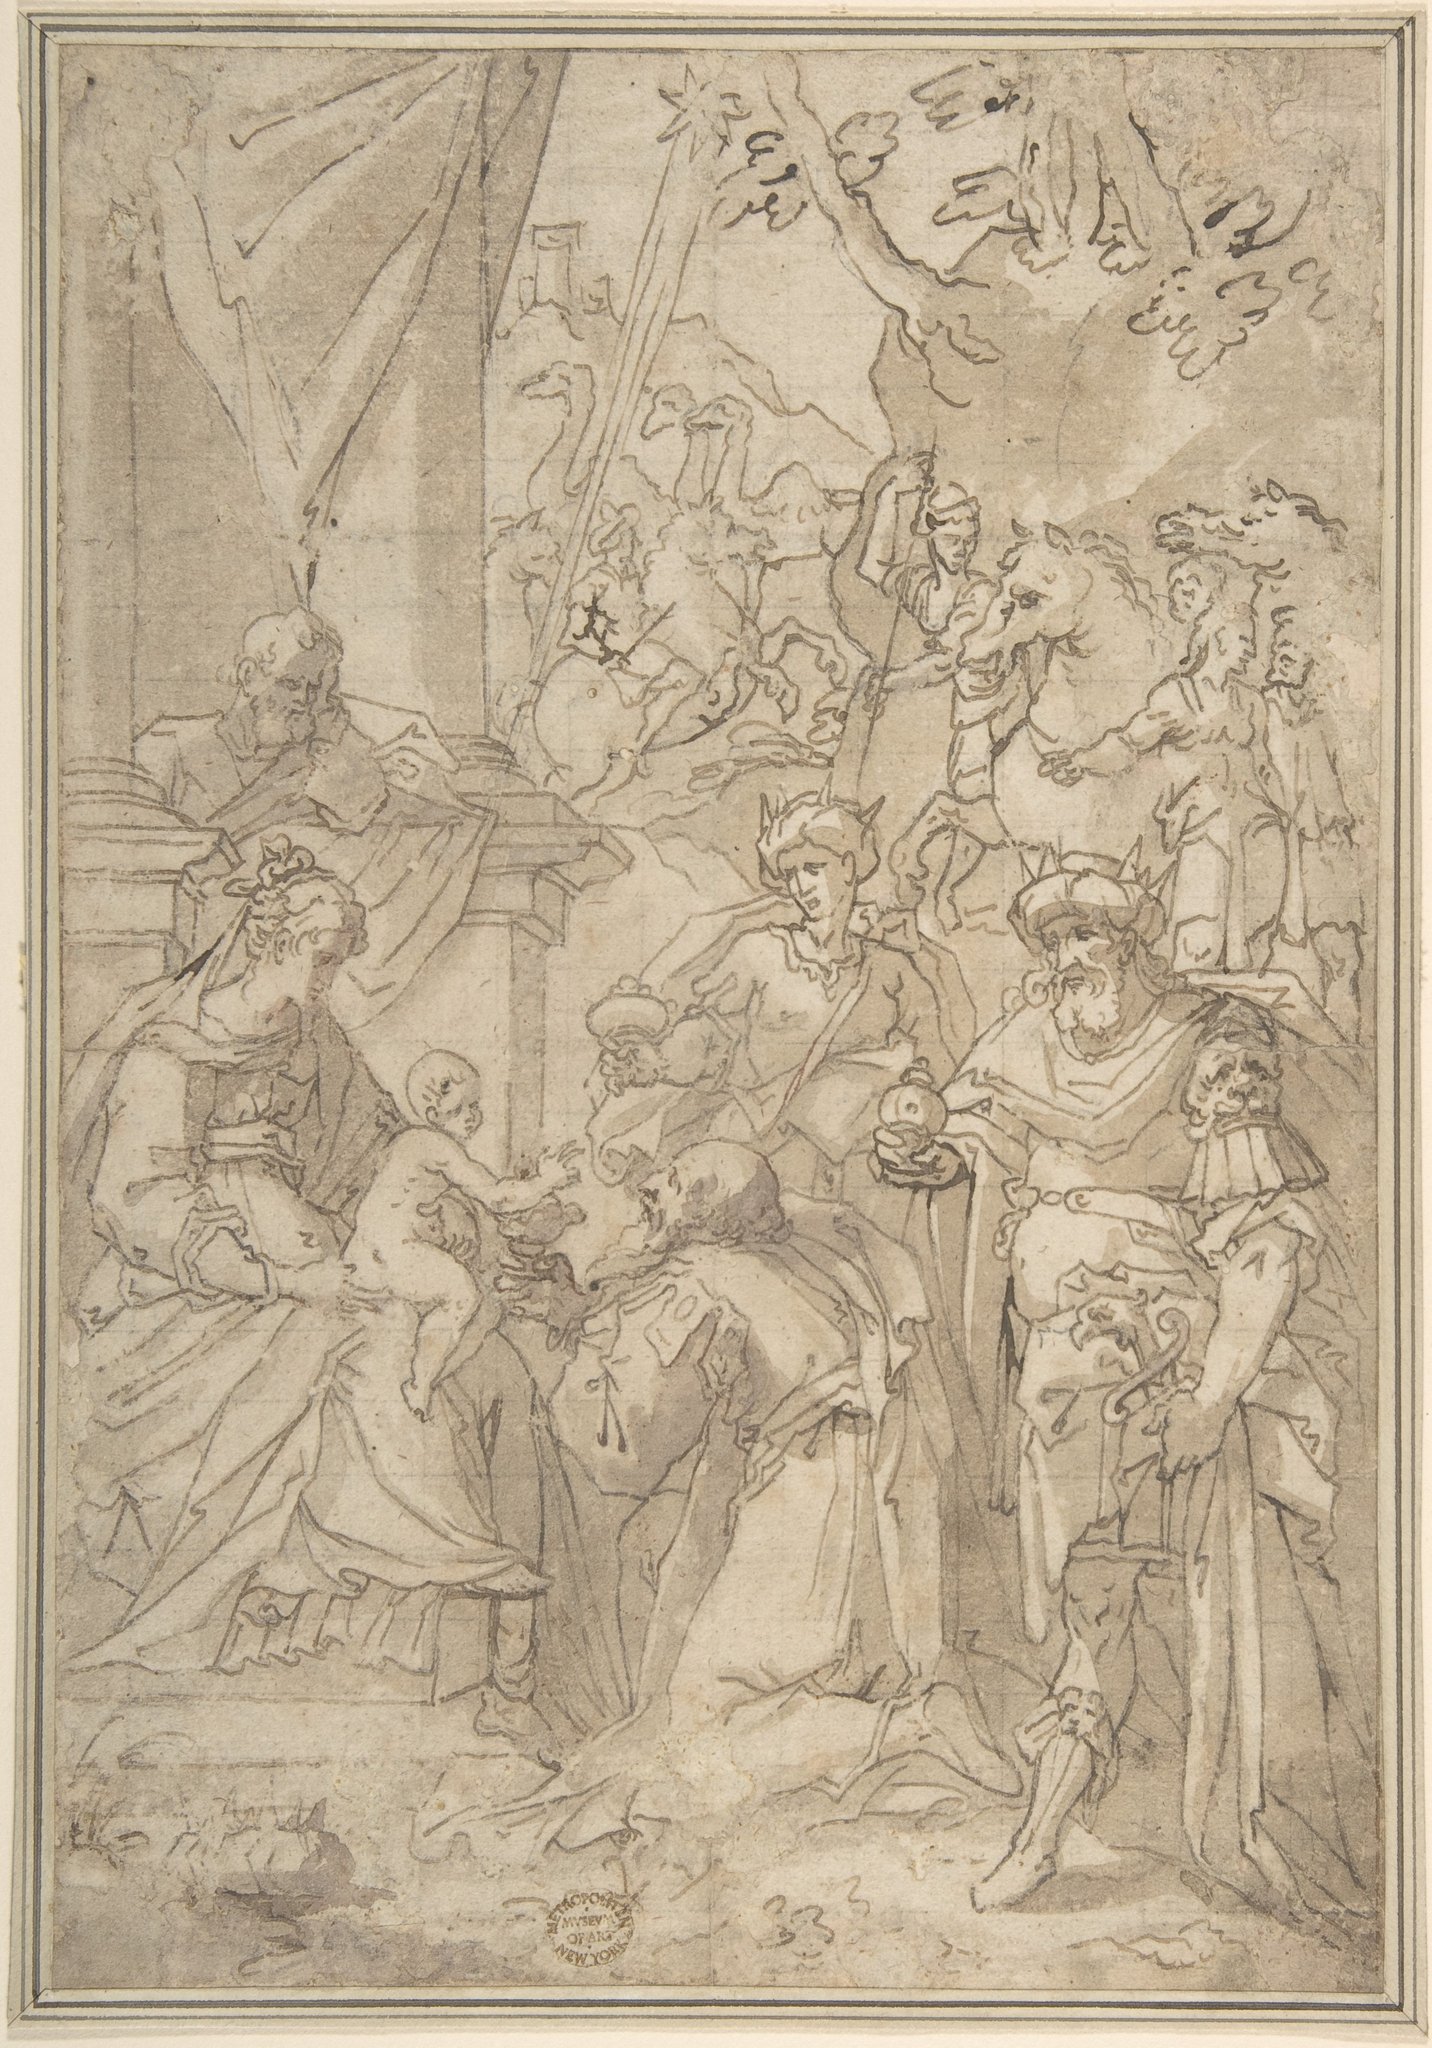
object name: drawing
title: Adoration of the Magi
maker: anonymous, italian, genoese, 16th century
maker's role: artist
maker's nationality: italian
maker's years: 1500-1600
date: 1501-1600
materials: ink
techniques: pen, wash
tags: men,madonna and child,adoration of the magi